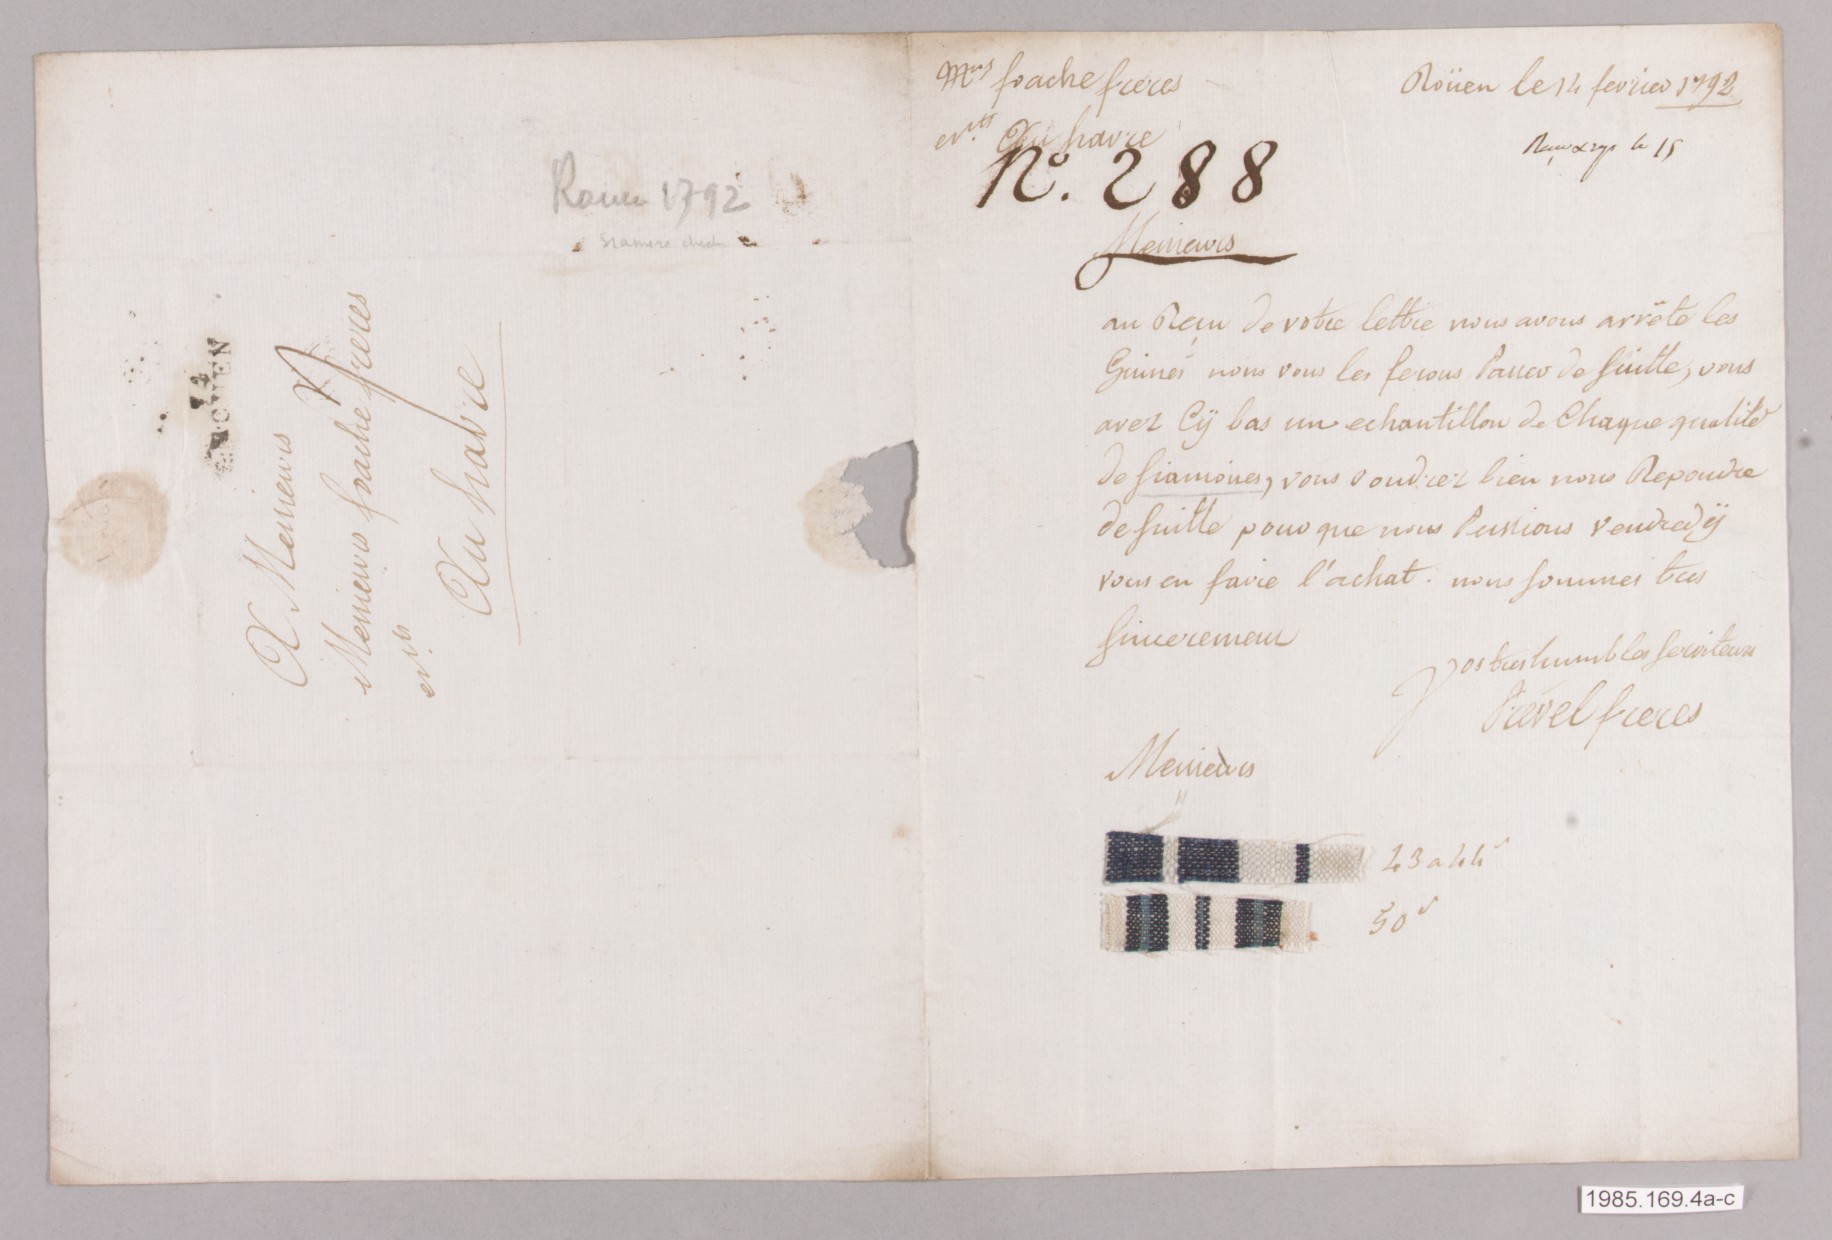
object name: letter with textile sample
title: Letter with textile samples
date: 1767-1833